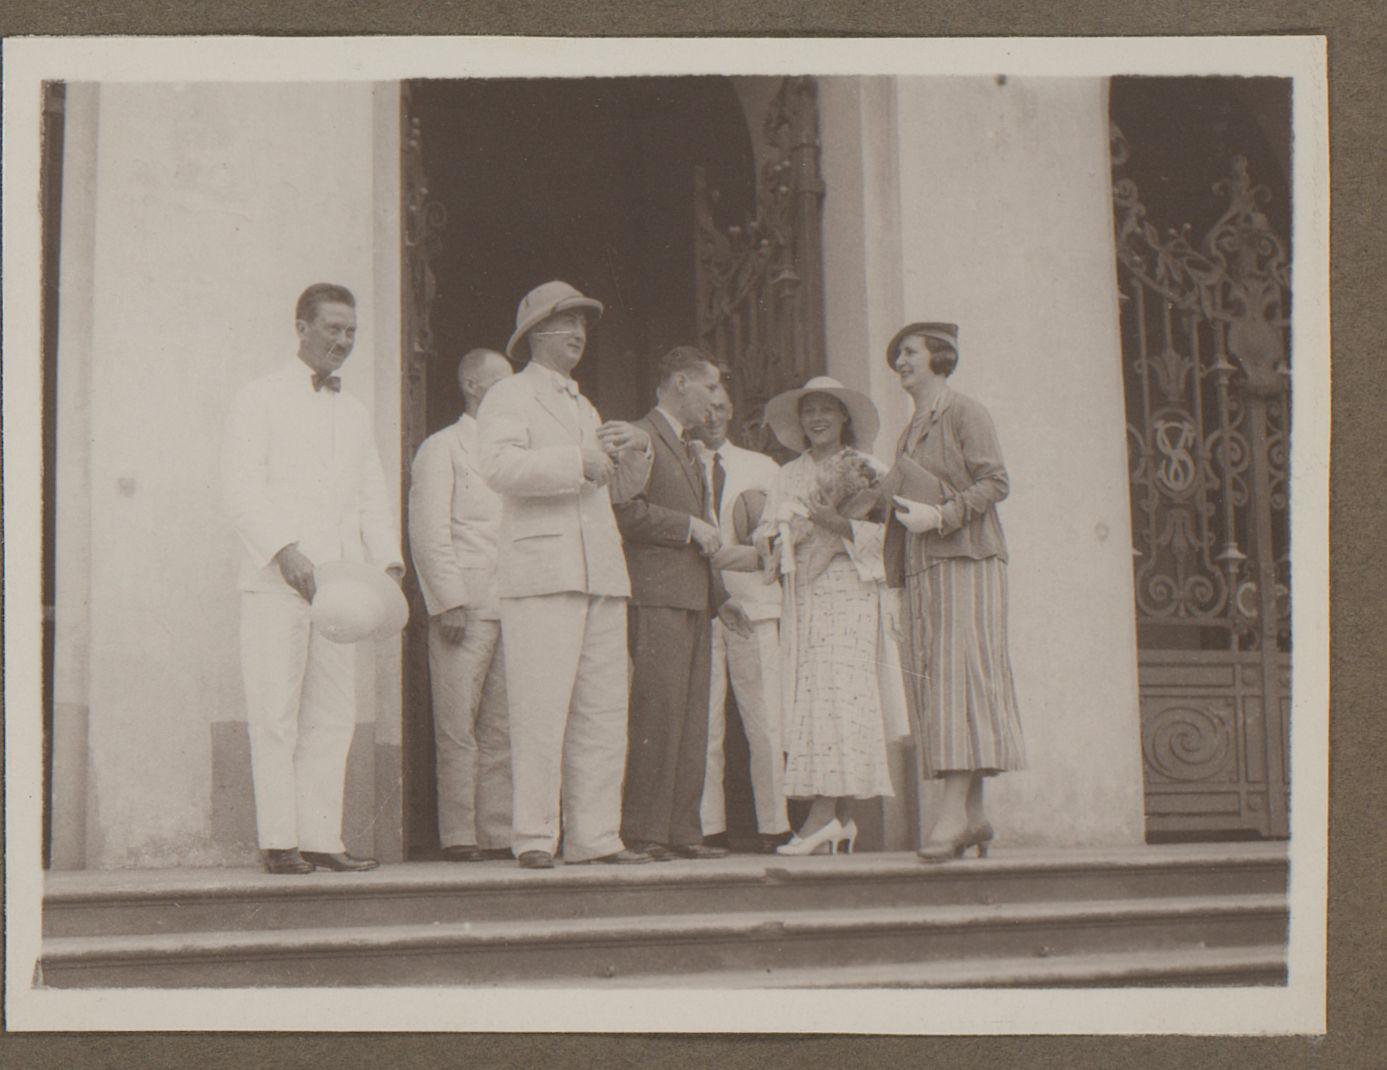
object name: photograph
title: Gezelschap voor een gebouw in Batavia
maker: Anonymous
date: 1934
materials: paper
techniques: gelatin silver print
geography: batavia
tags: anonymous historical persons portrayed in a group, in a group-portrait, batavia